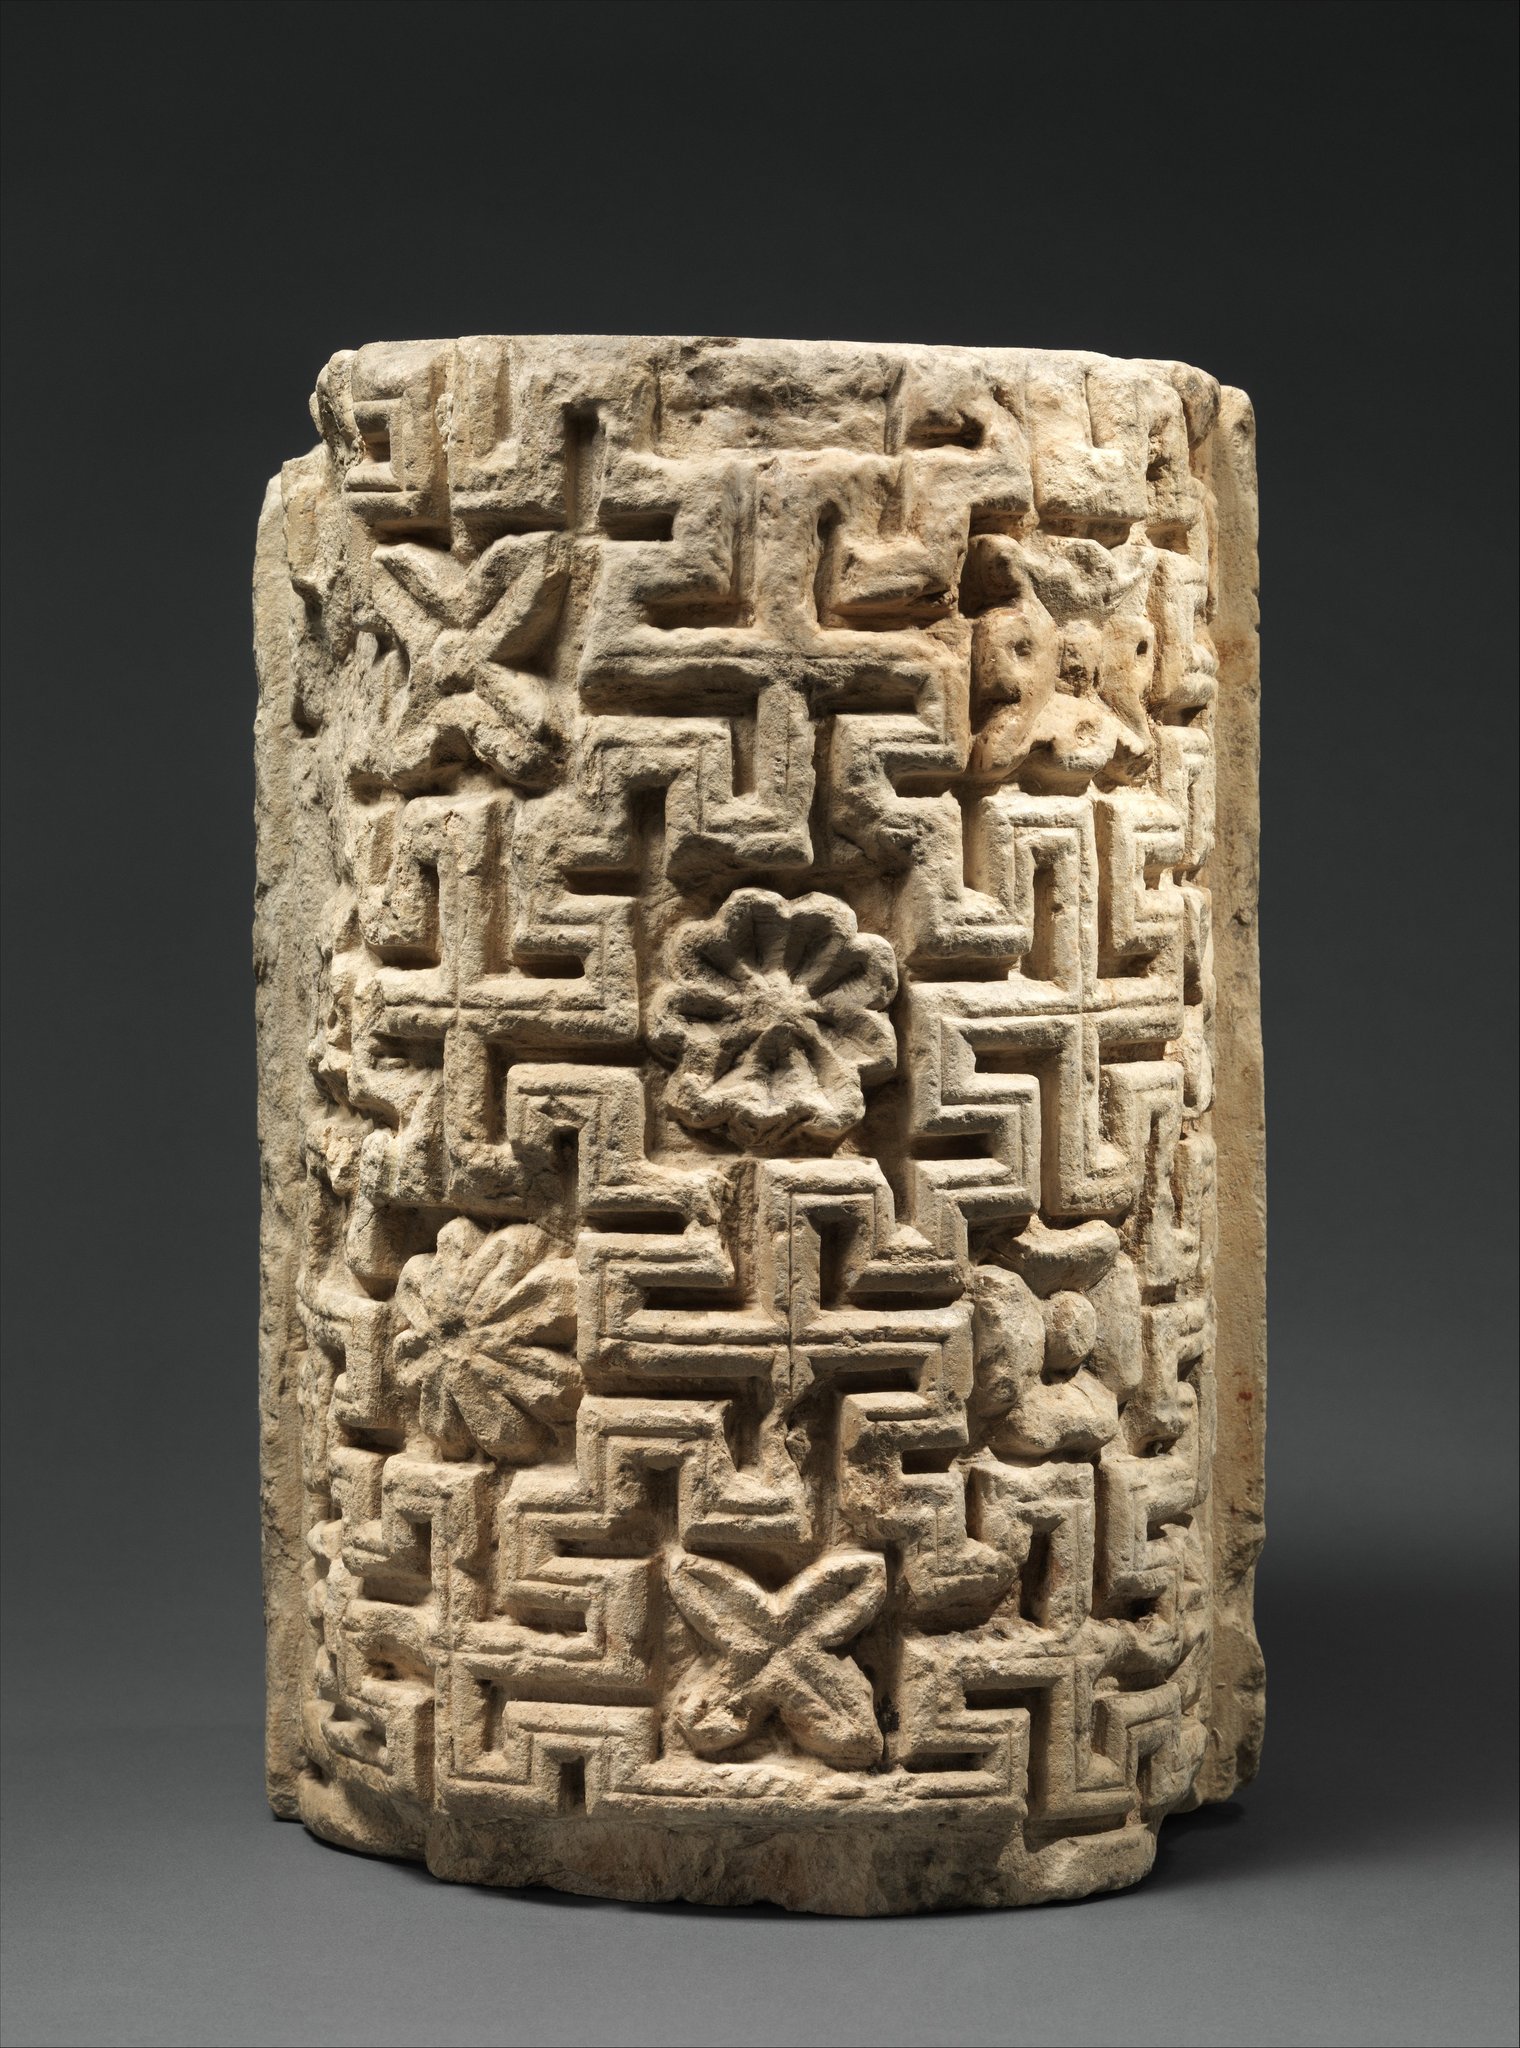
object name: column fragment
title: Engaged Column Part with Meander Pattern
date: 501-600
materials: limestone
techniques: carving, relief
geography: egypt